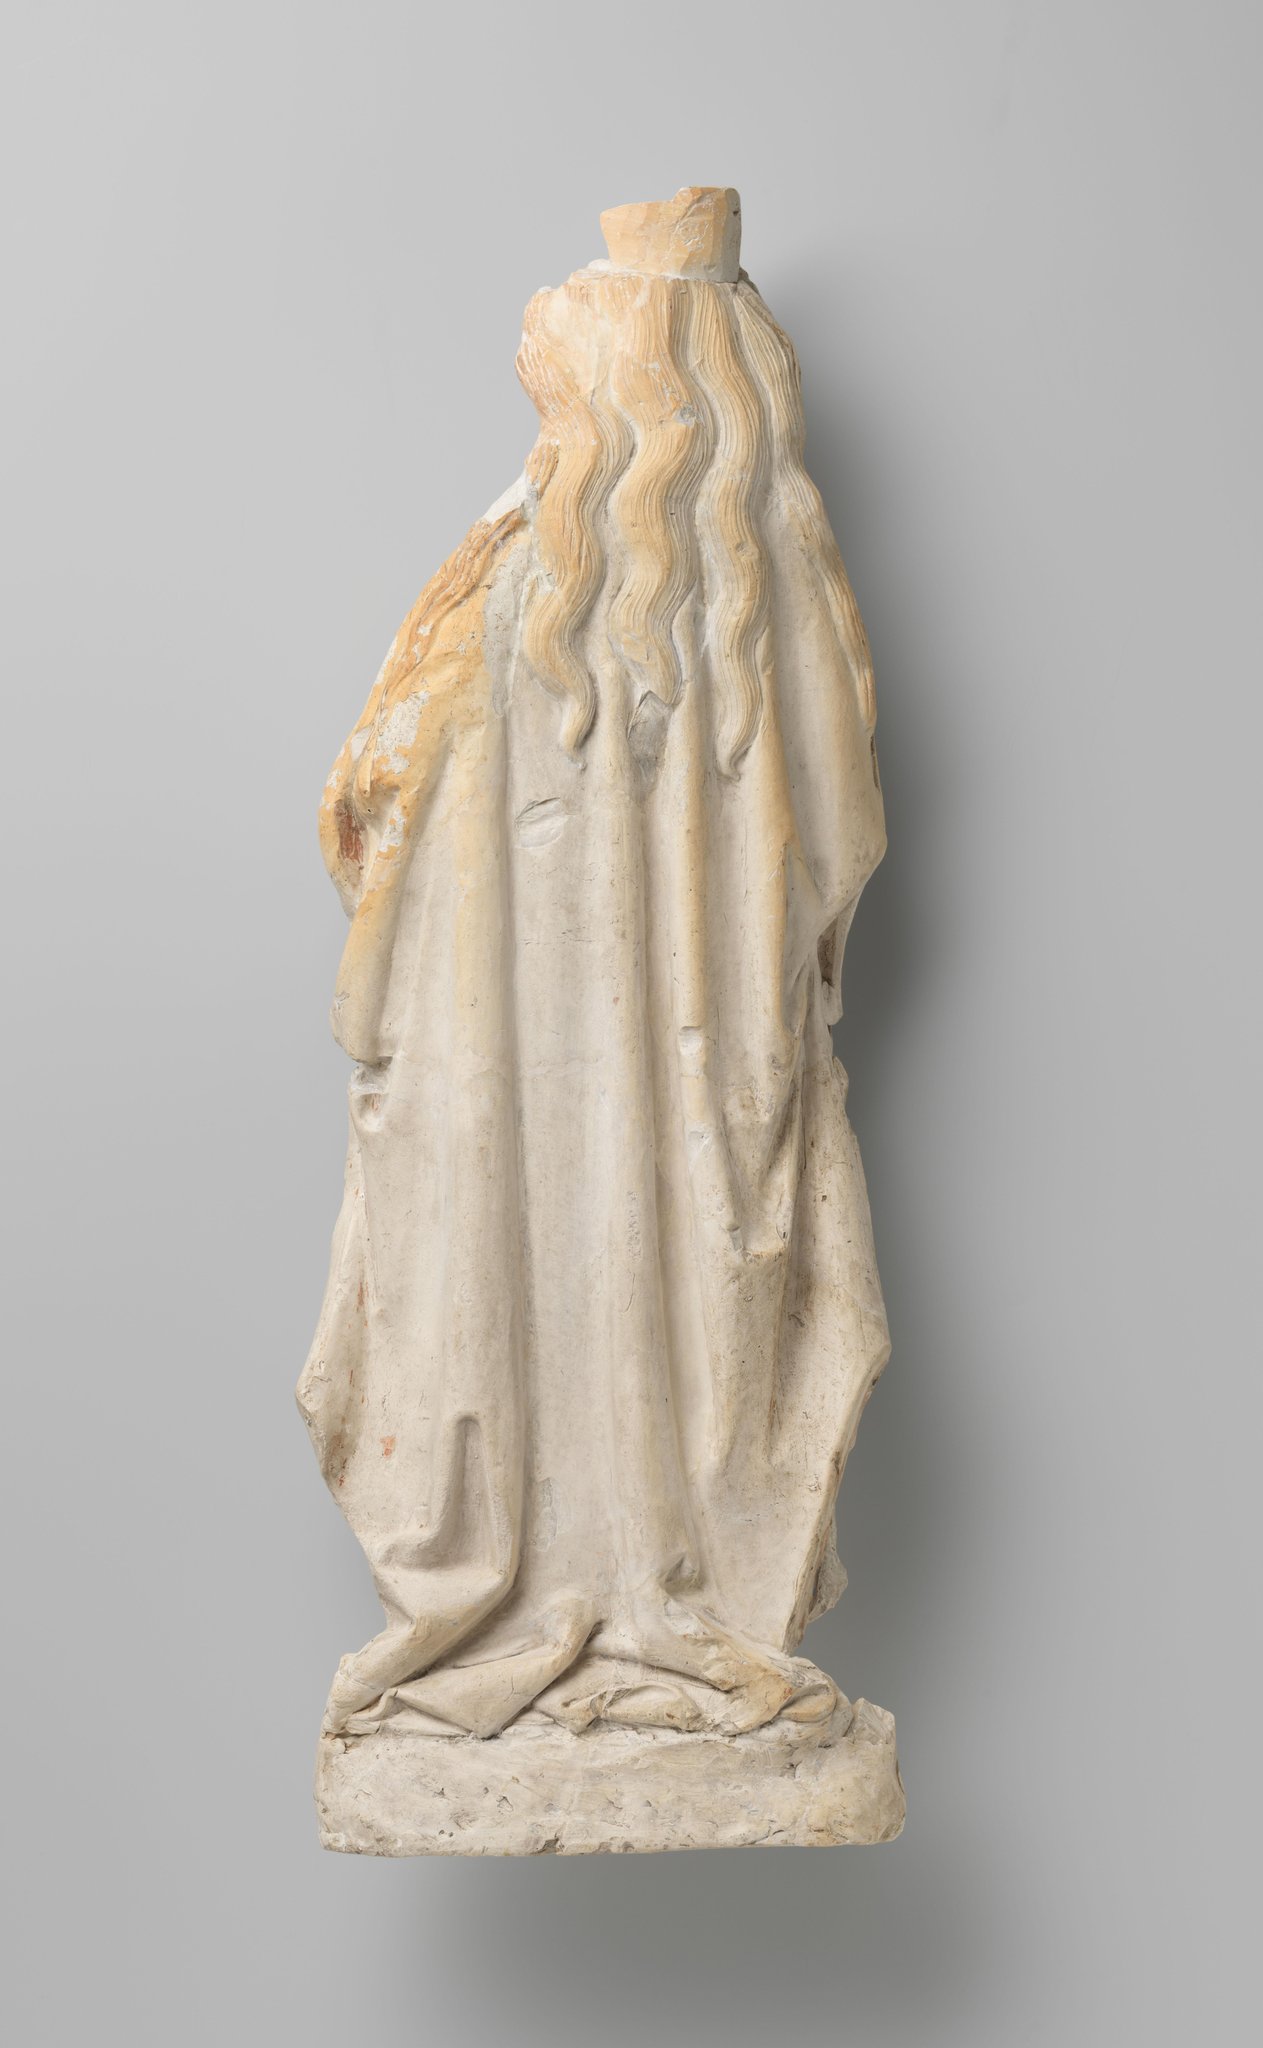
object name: sculpture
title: Rug van een vrouwelijke heilige, waarschijnlijk een Maria met kind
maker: Anonymous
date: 1470-1480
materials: clay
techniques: gilding, polychromy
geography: utrecht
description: Rug behorend bij losse kop?? Het haar valt over schouders en rug. De rug is vrij vlak.